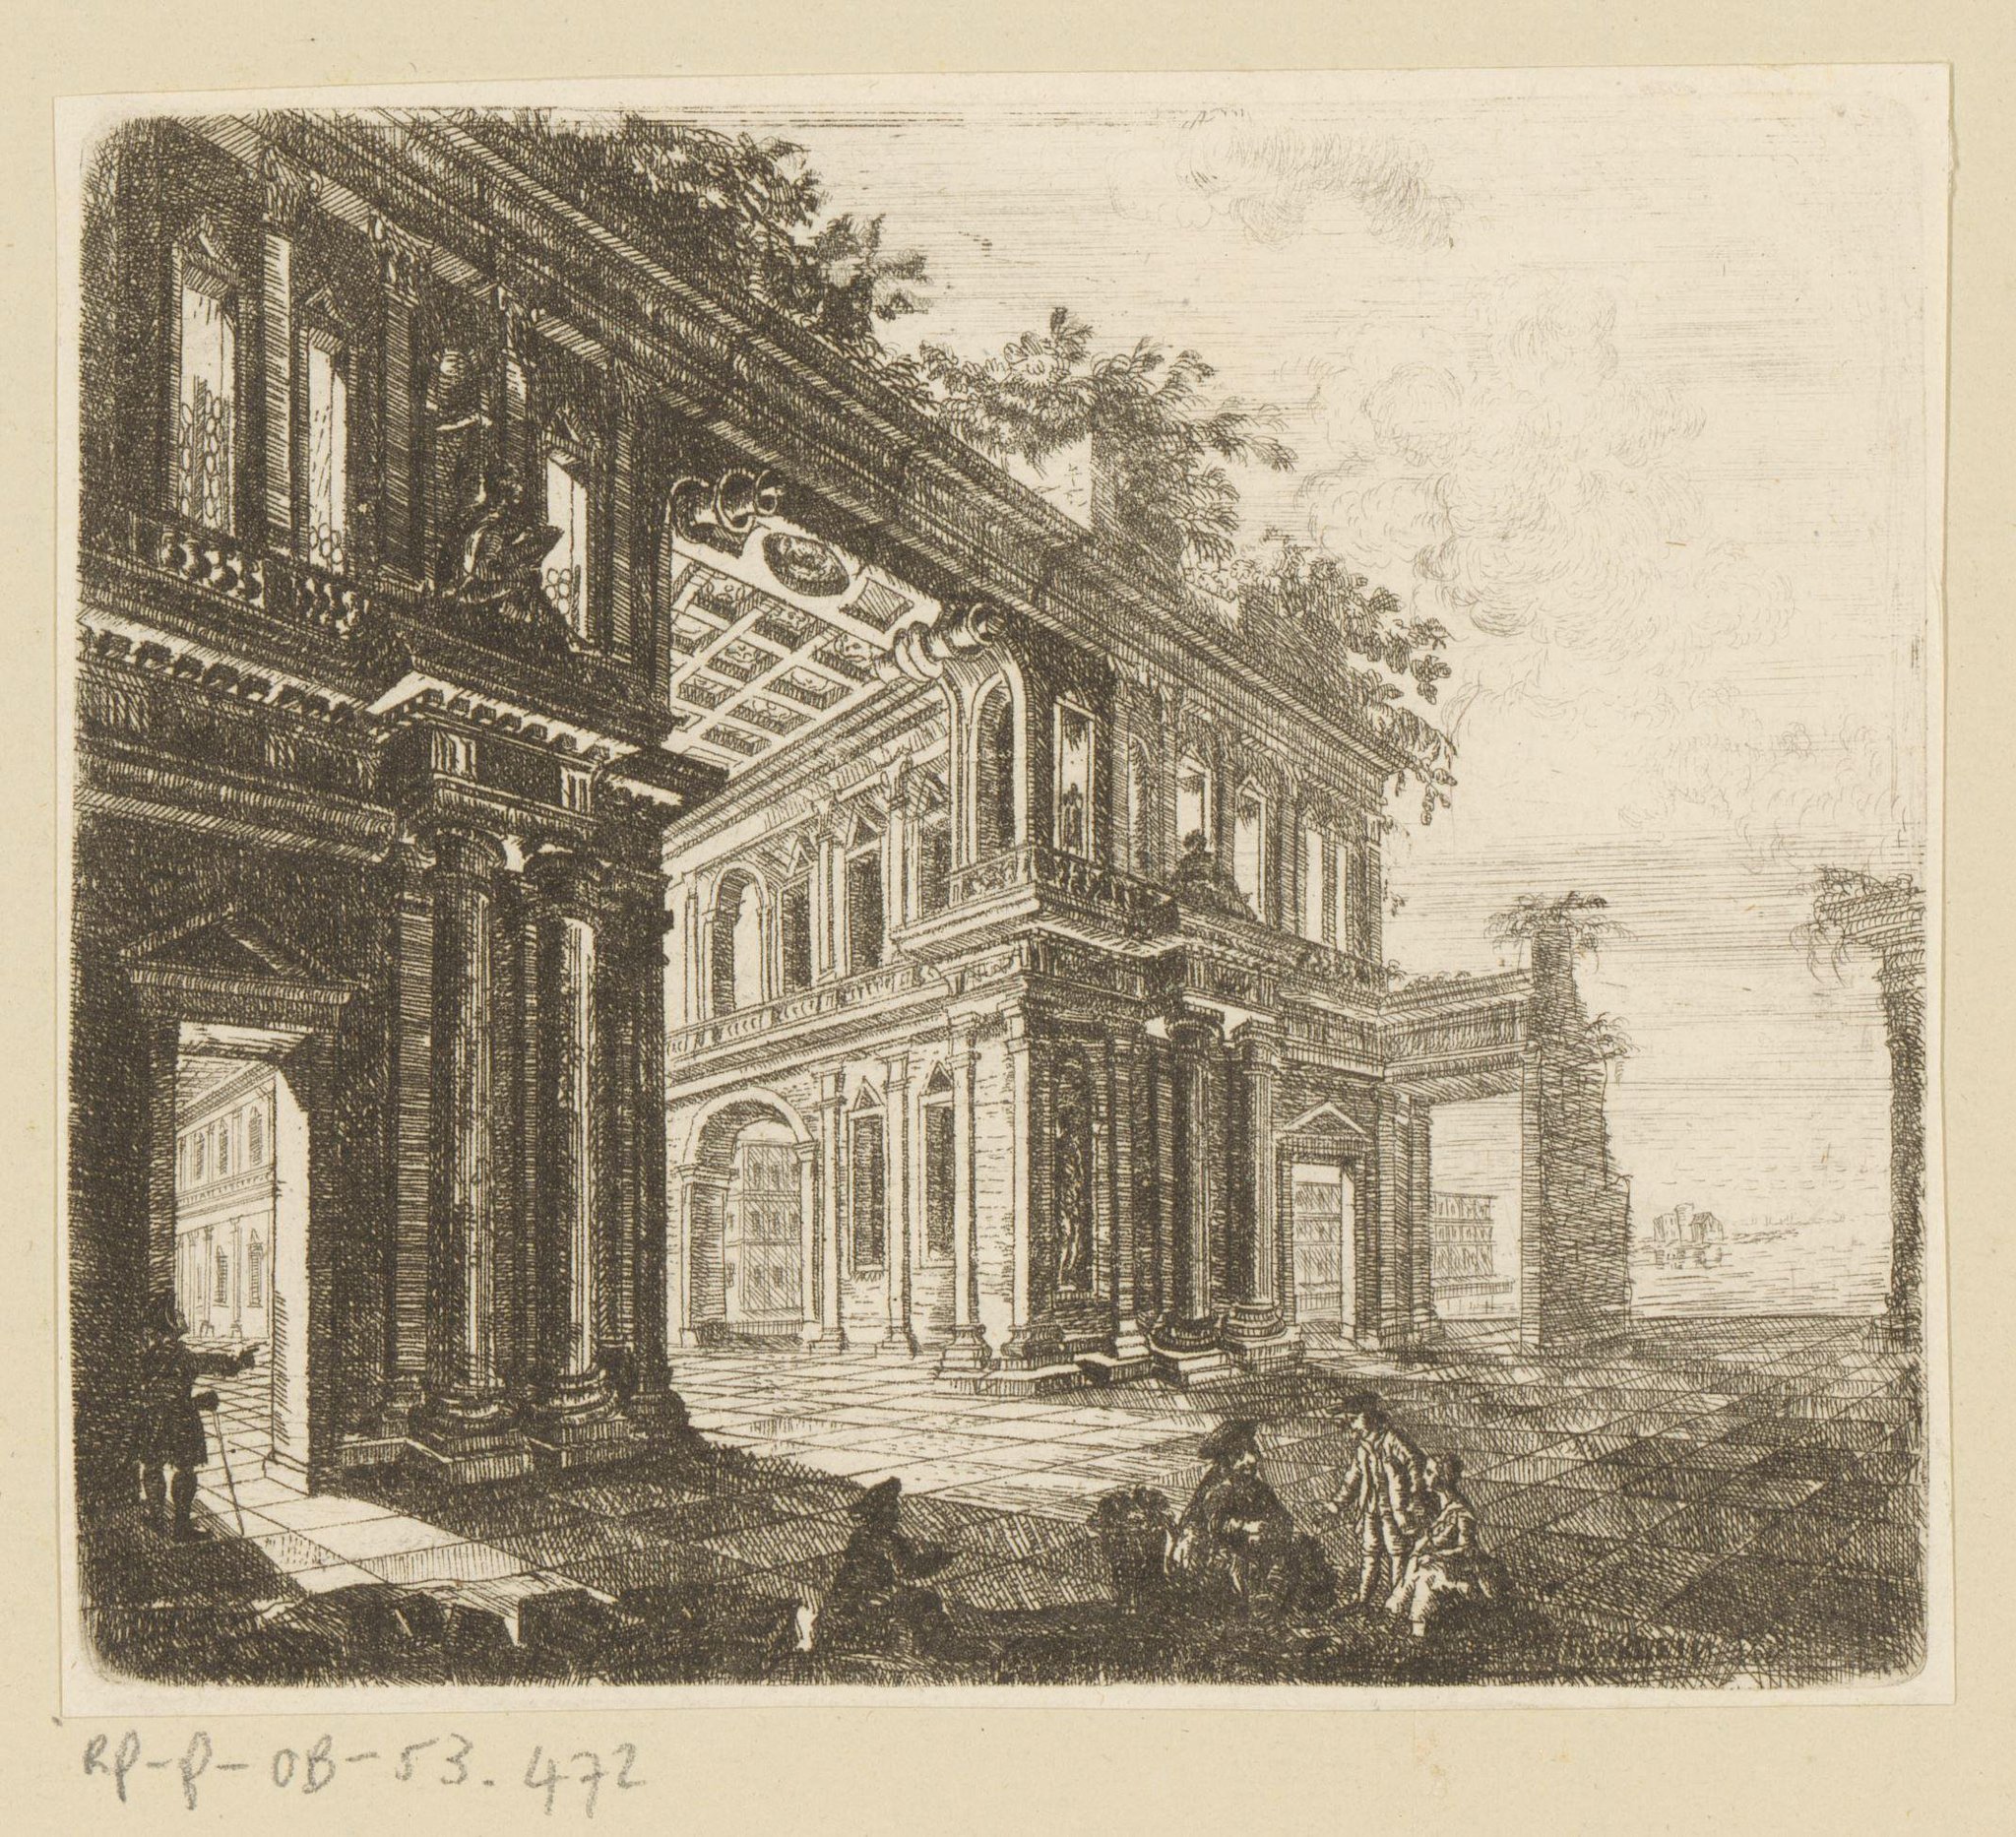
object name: print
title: Fantasie architectuur met enkele figuren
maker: johann andreas benjamin nothnagel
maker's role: print maker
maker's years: 1729-1804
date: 1739-1804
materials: paper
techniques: etching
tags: fantastic architecture, unrealistic architectural fantasies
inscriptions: collector's mark: Lugt 240